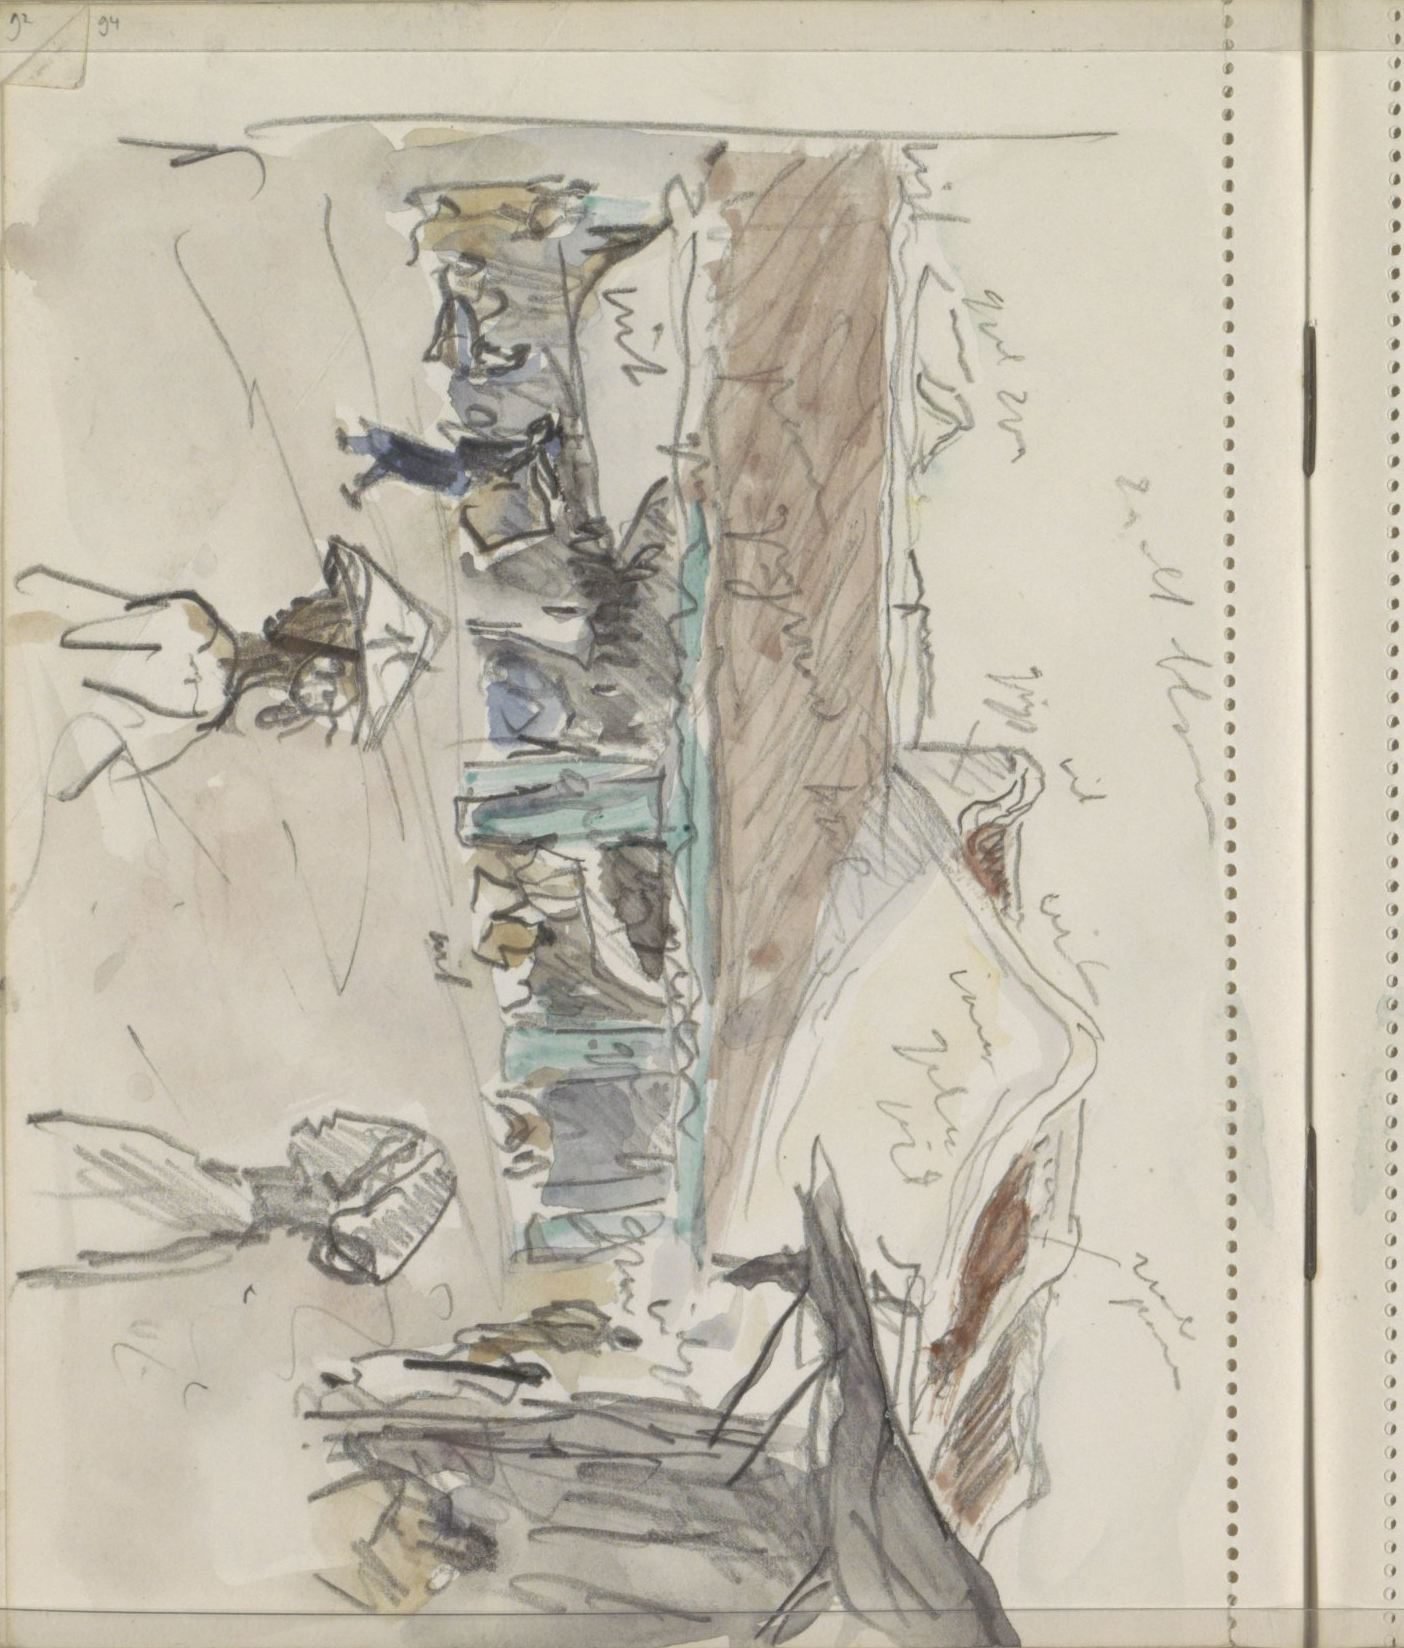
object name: sketchbook leaf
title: Straat met figuren en huizen met luifels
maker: marius bauer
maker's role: draughtsman, print maker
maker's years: 1867-1932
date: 1925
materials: paper, pencil, watercolor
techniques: brush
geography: indonesia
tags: asiatic races and peoples, street (+ city(-scape) with figures, staffage)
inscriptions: kleurnotitie, handgeschreven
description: Pagina 94 uit een schetsboek met 67 bladen.